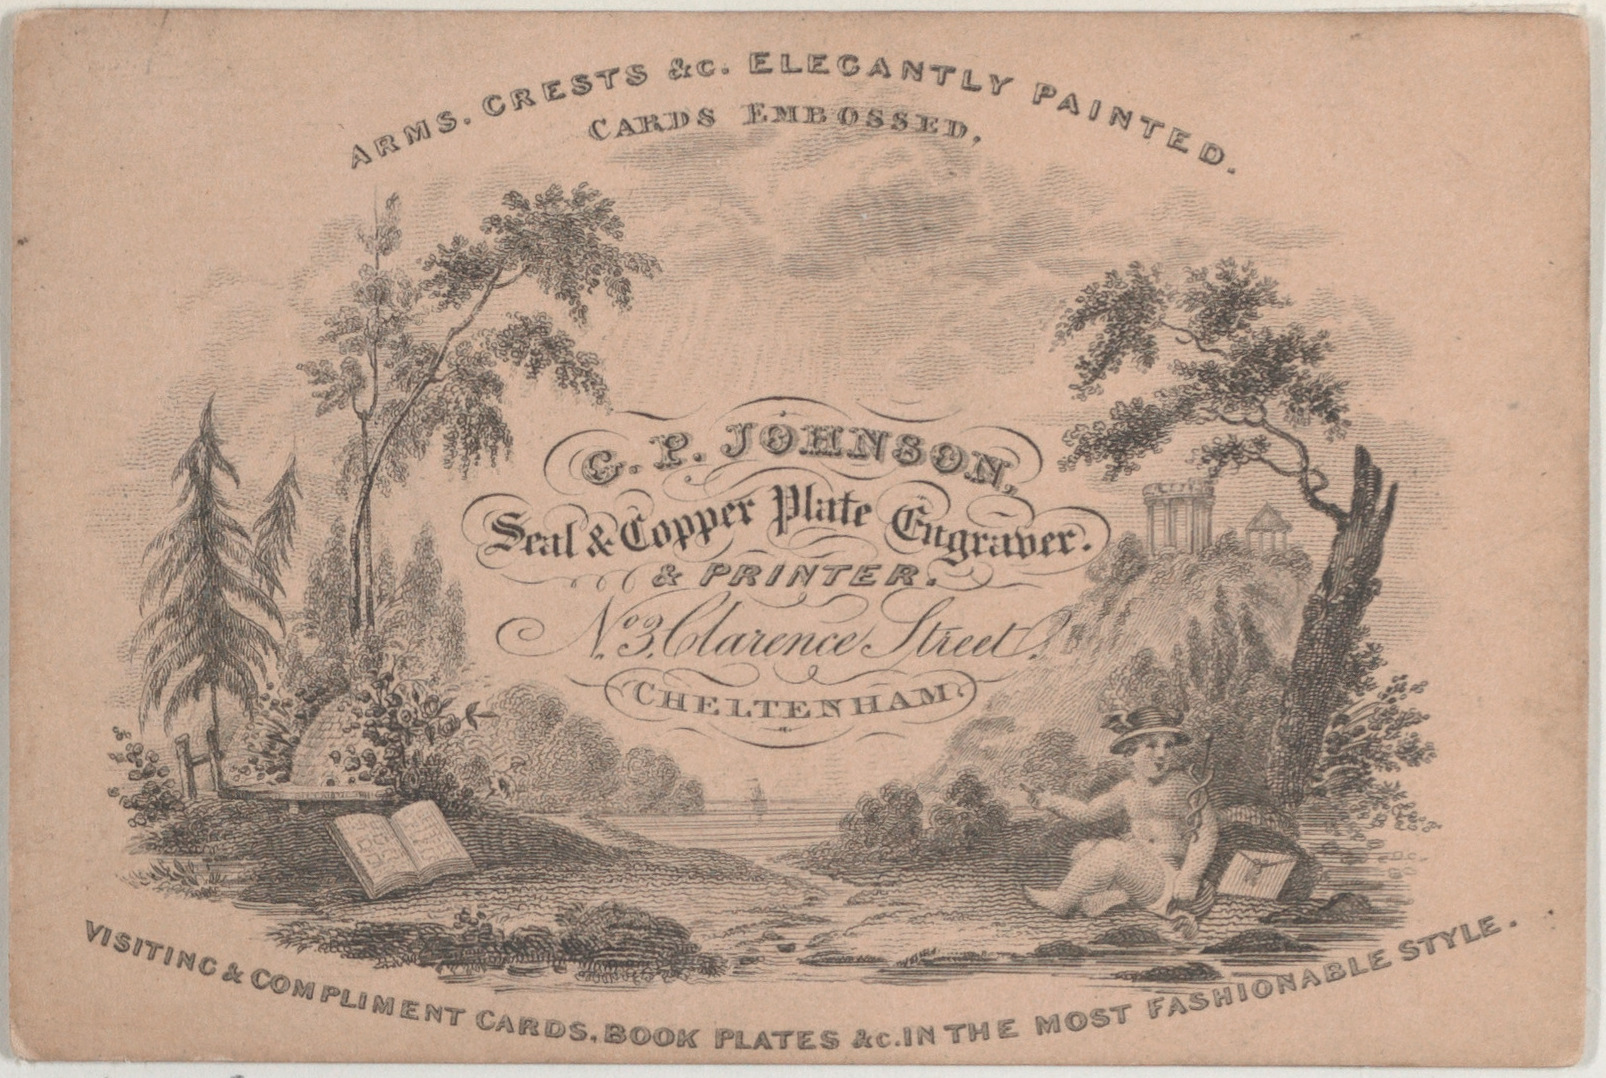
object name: print, trade card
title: Trade Card for C.P. Johnson, Seal and Copper Plate Engraver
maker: anonymous, british, 19th century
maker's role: artist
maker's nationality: british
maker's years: 1800-1900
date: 1801-1900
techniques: engraving